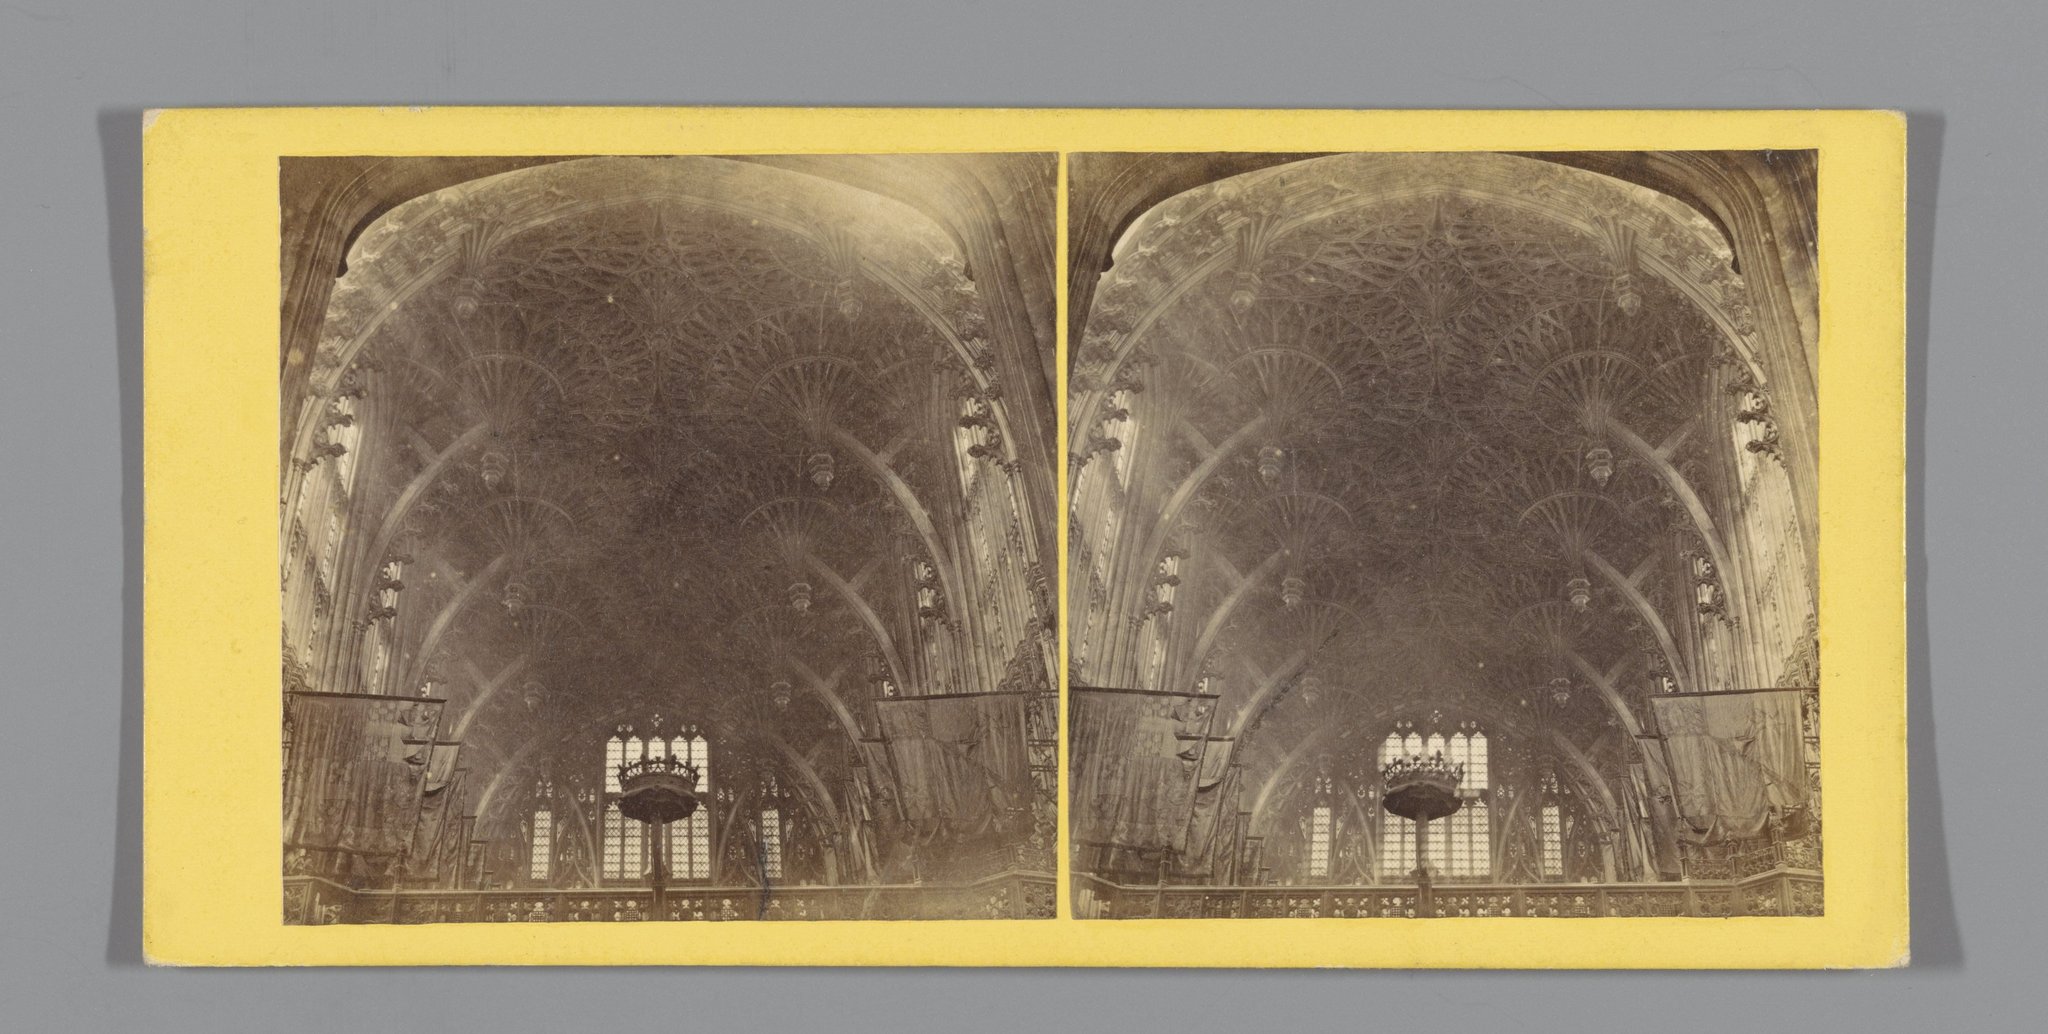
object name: stereograph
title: Gewelf van de Henry VII Chapel in Westminster Abbey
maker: Anonymous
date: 1850-1880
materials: cardboard, photographic support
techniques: albumen print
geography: westminster abbey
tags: parts of church interior: vault, parts of church interior: chapel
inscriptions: number: ‘No. 200.’